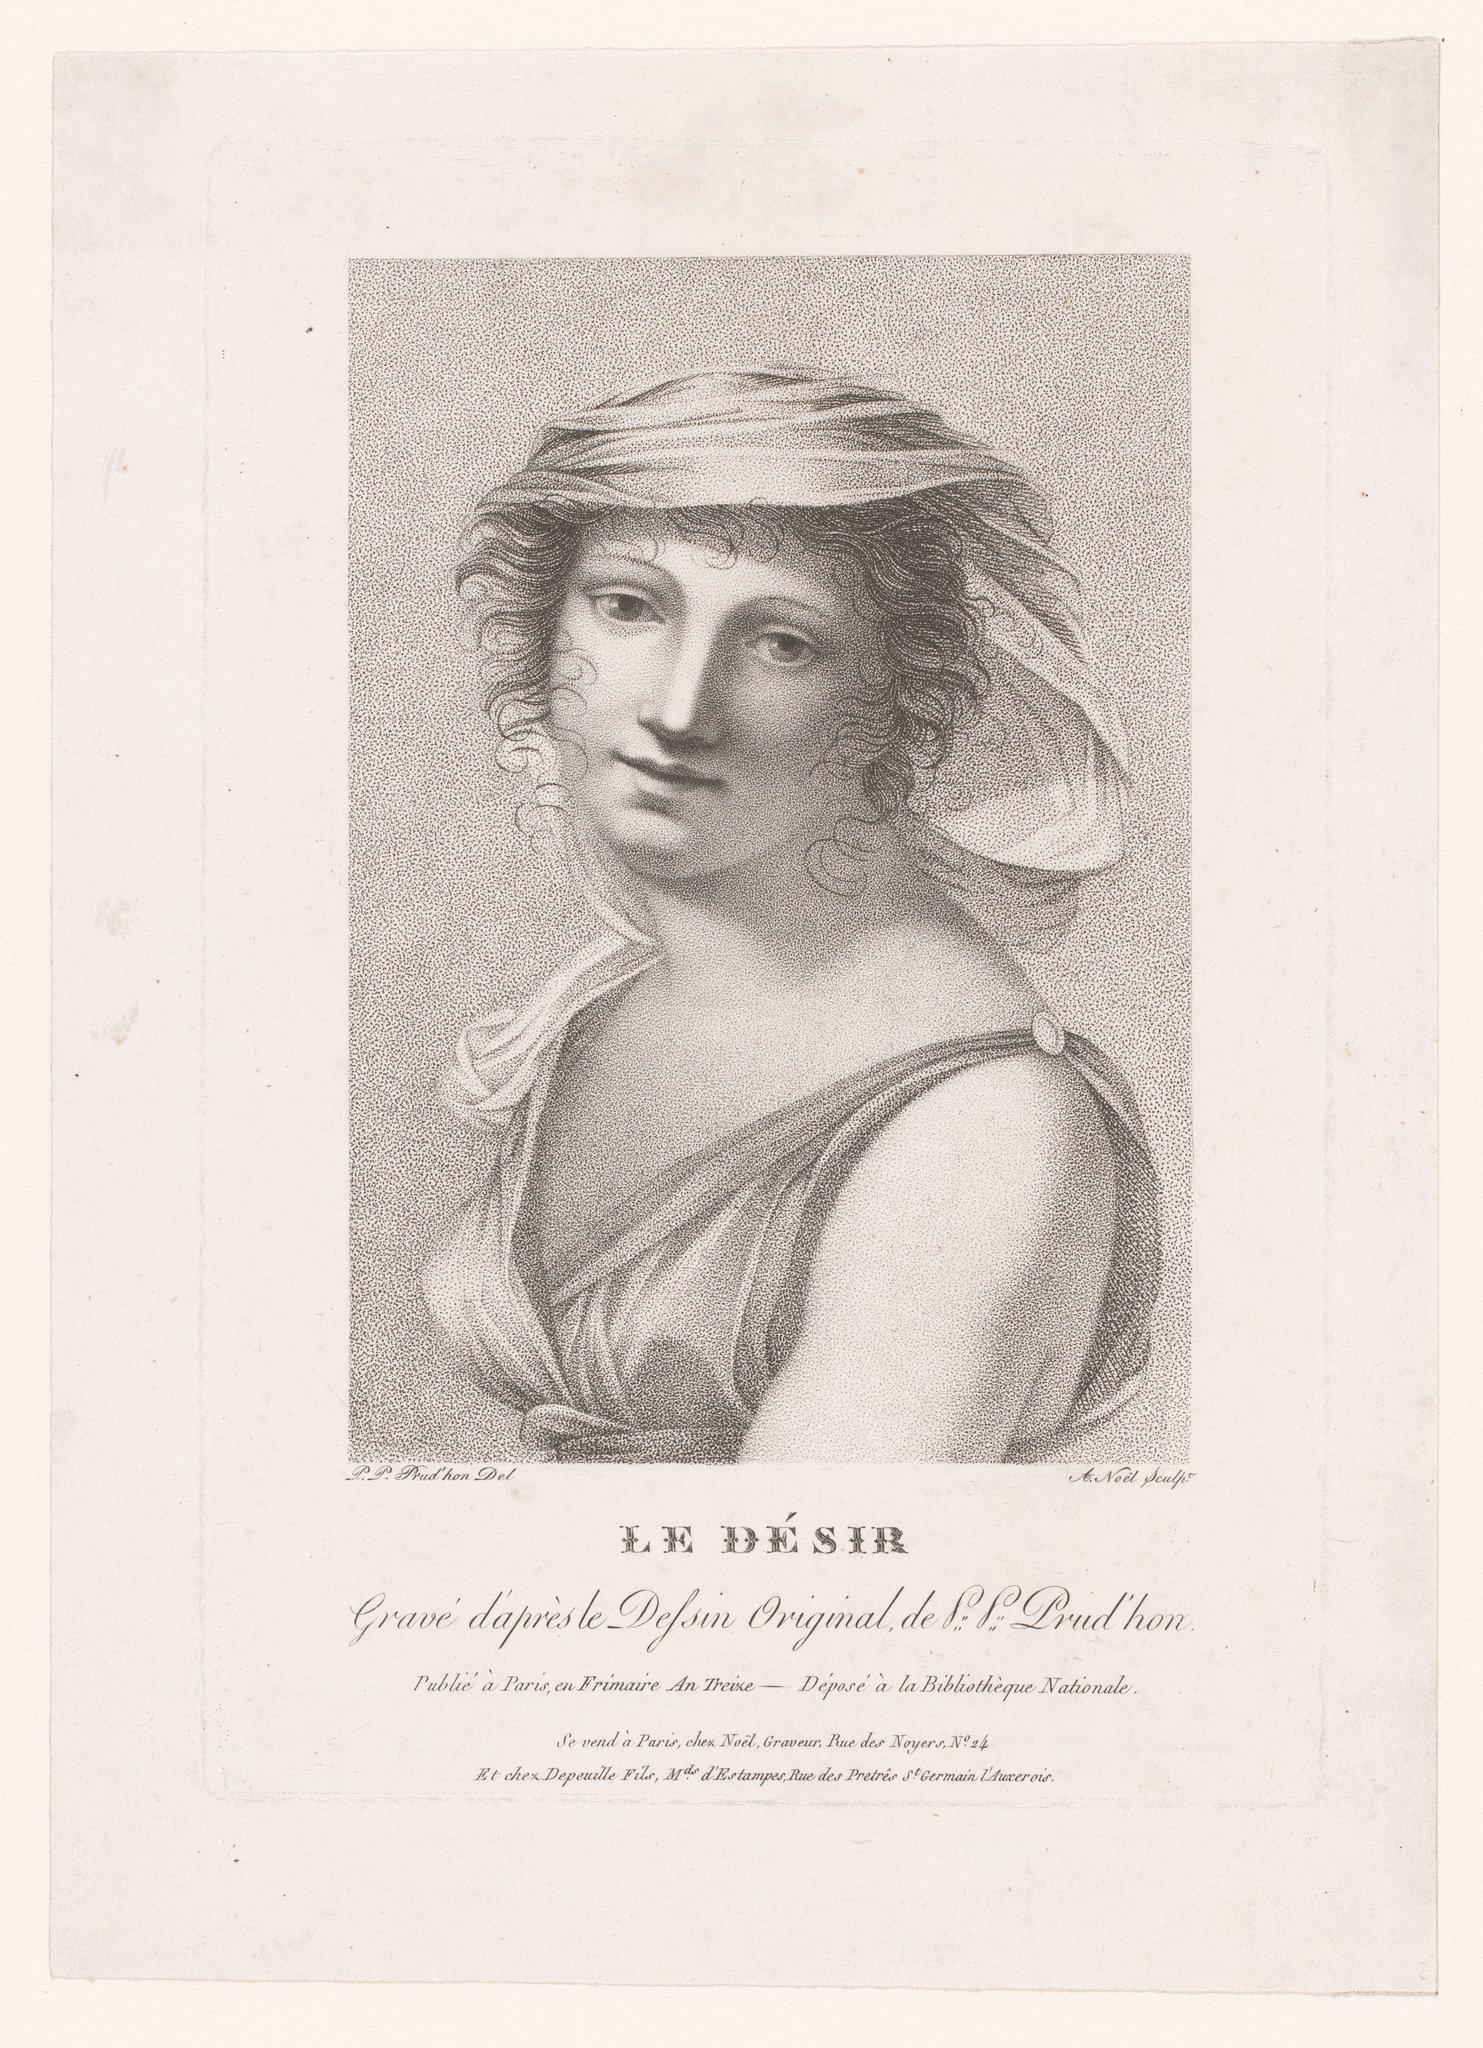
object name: print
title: Le Désir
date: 1804-1805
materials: paper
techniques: etching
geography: paris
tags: adult woman, desire; 'desiderio' (ripa)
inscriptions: collector's mark: Lugt 2228